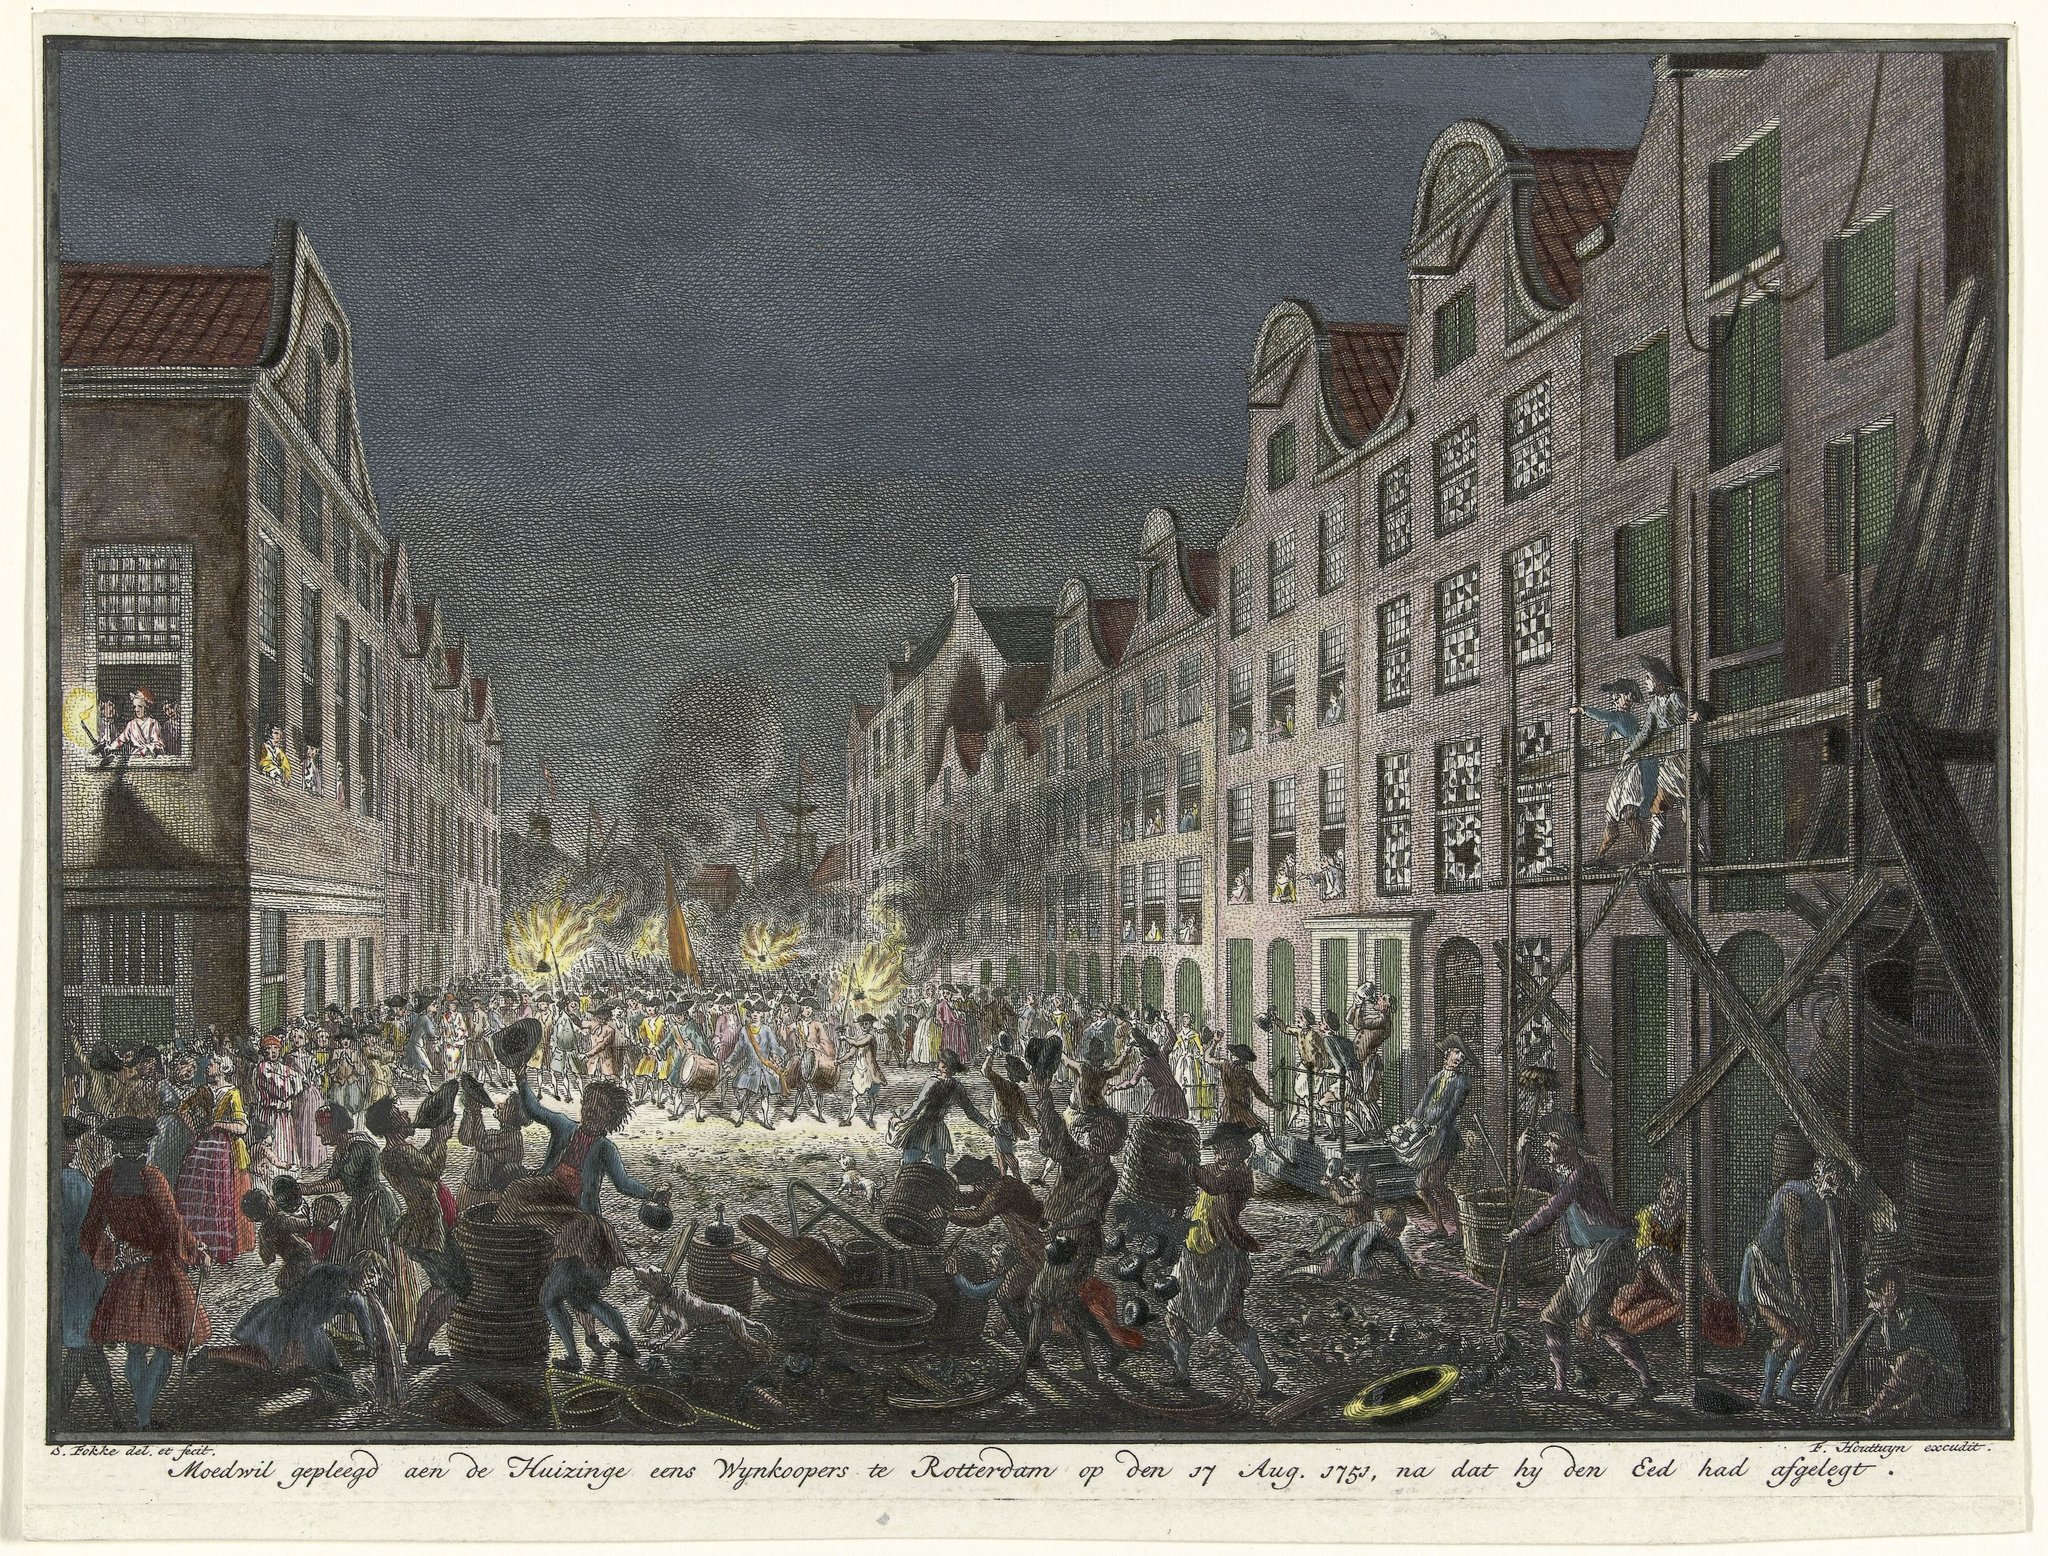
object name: print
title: Moedwil gepleegd aan de Huizinge eens Wynkoopers te Rotterdam op den 17 Aug. 1751, na dat hy den Eed had afgelegt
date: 1751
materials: paper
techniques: etching, hand coloring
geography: northern netherlands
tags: plundering ~ riot, rotterdam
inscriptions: collector's mark: Lugt 2228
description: Plundering van het huis van de wijnkoper Gerrit Hagedooren (Hagedoorn) in de Bierstraat te Rotterdam in de avond van 17 augustus 1751 nadat hij de eed had afgelegd. Rellen in een straat met rechts het huis van de wijnkoper met ingegooide ramenen en met plunderaars die zich te goed doen aan opengebroken wijnvaten. Verderop in de straat de aankomst van een detachement schutters.